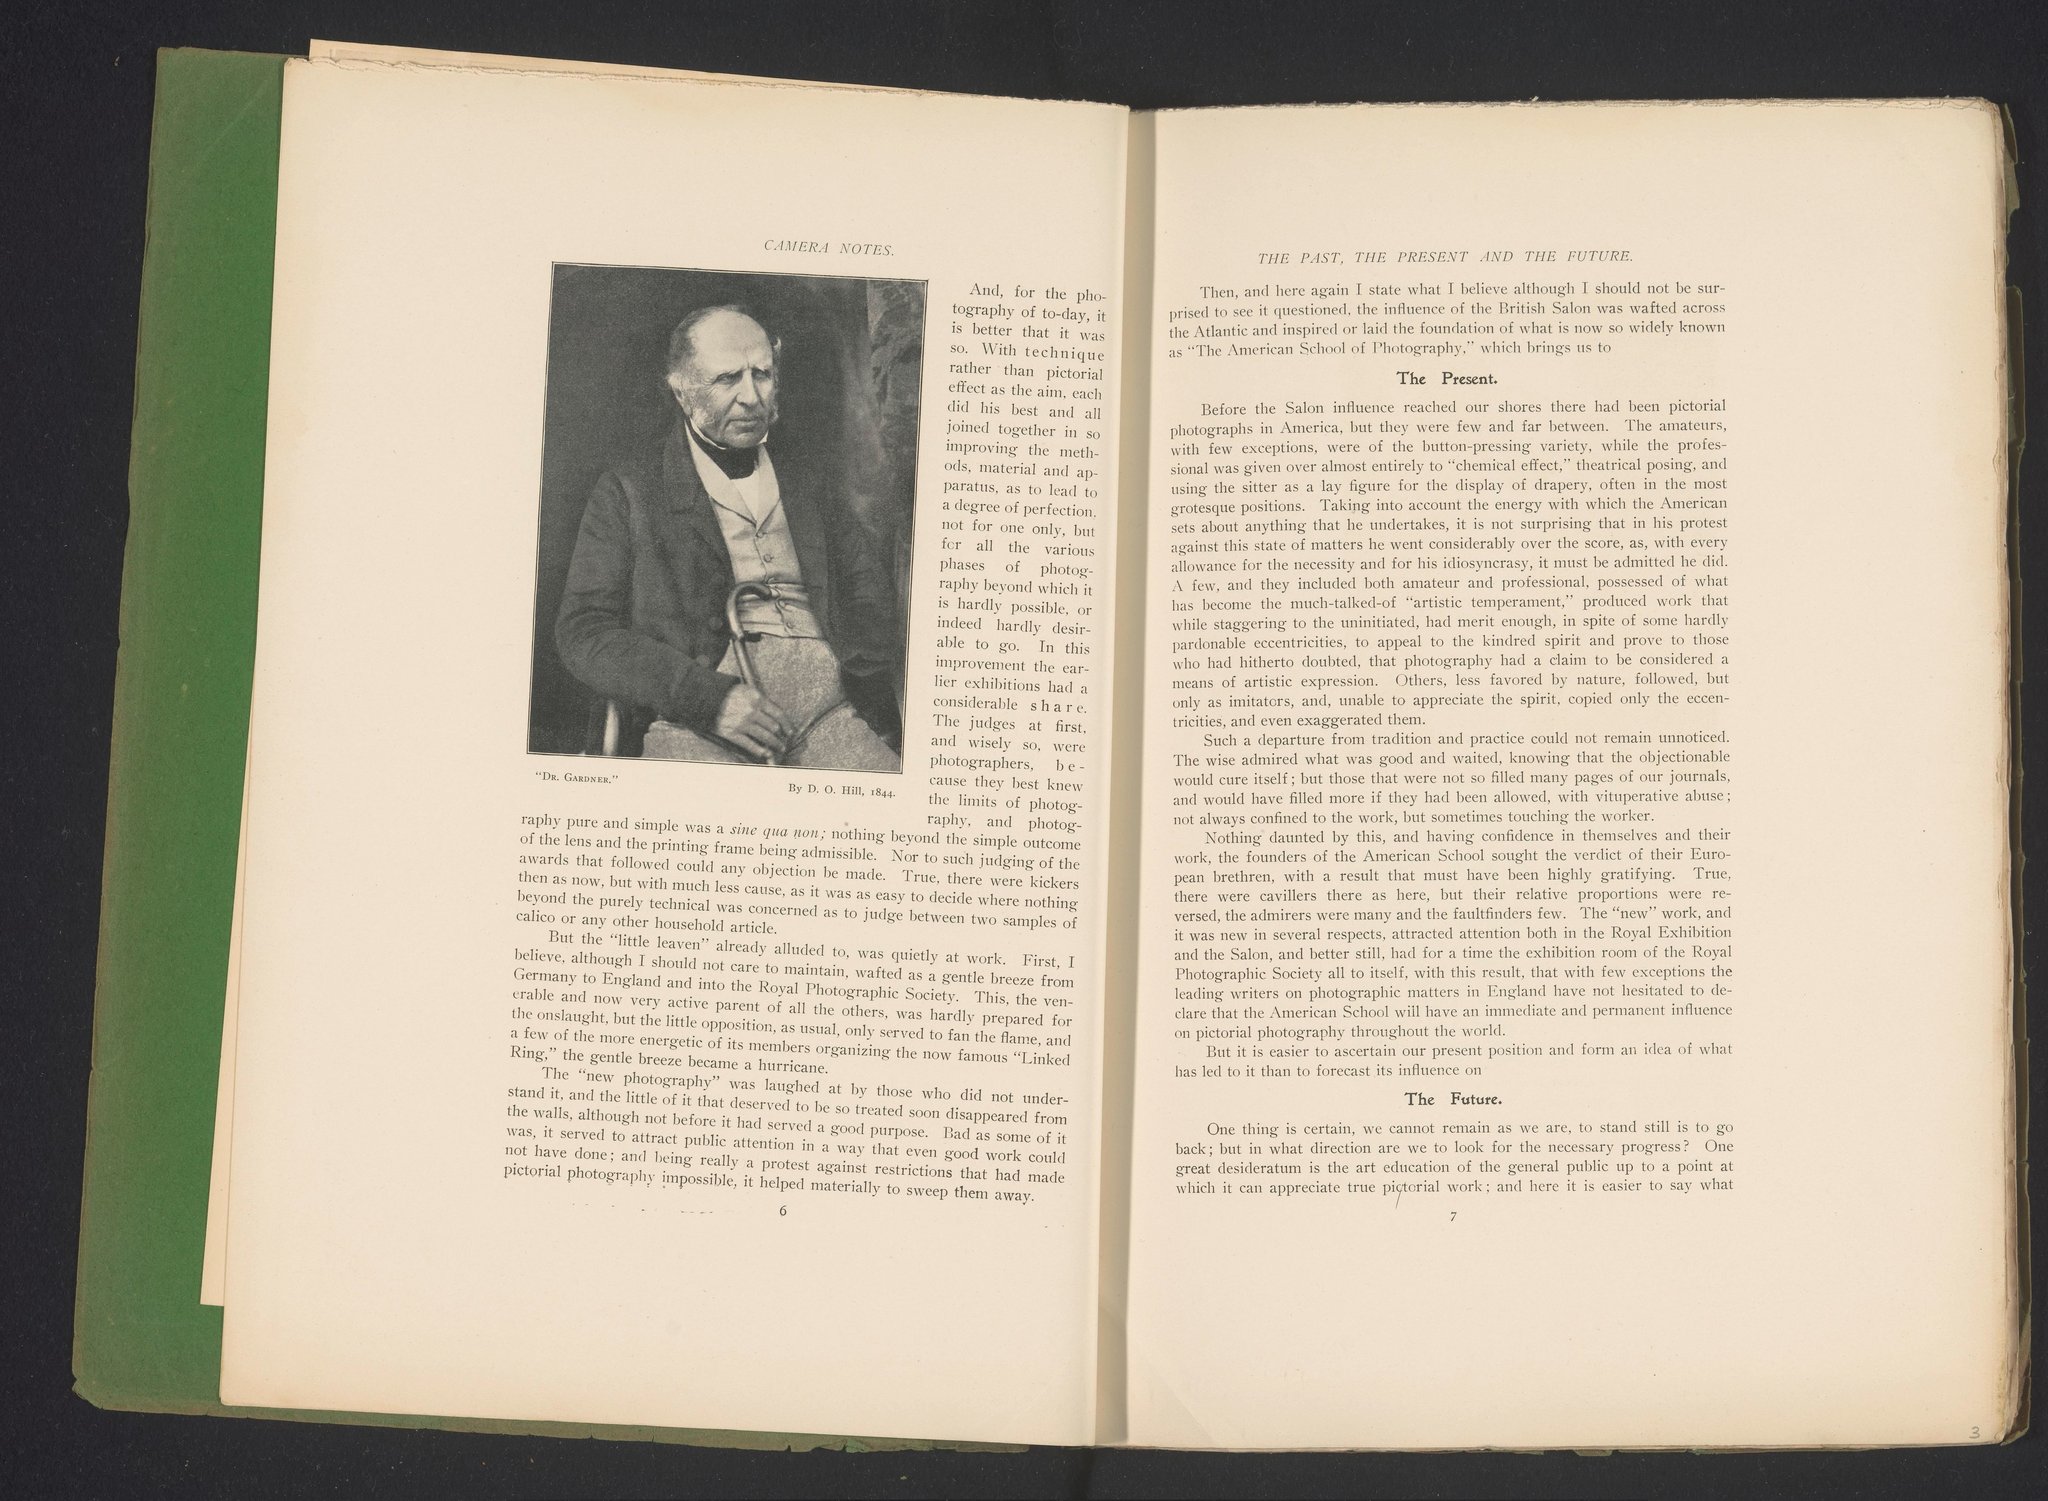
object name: photomechanical print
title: Dr. Gardner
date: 1844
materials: paper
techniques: autotype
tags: historical persons not known by name